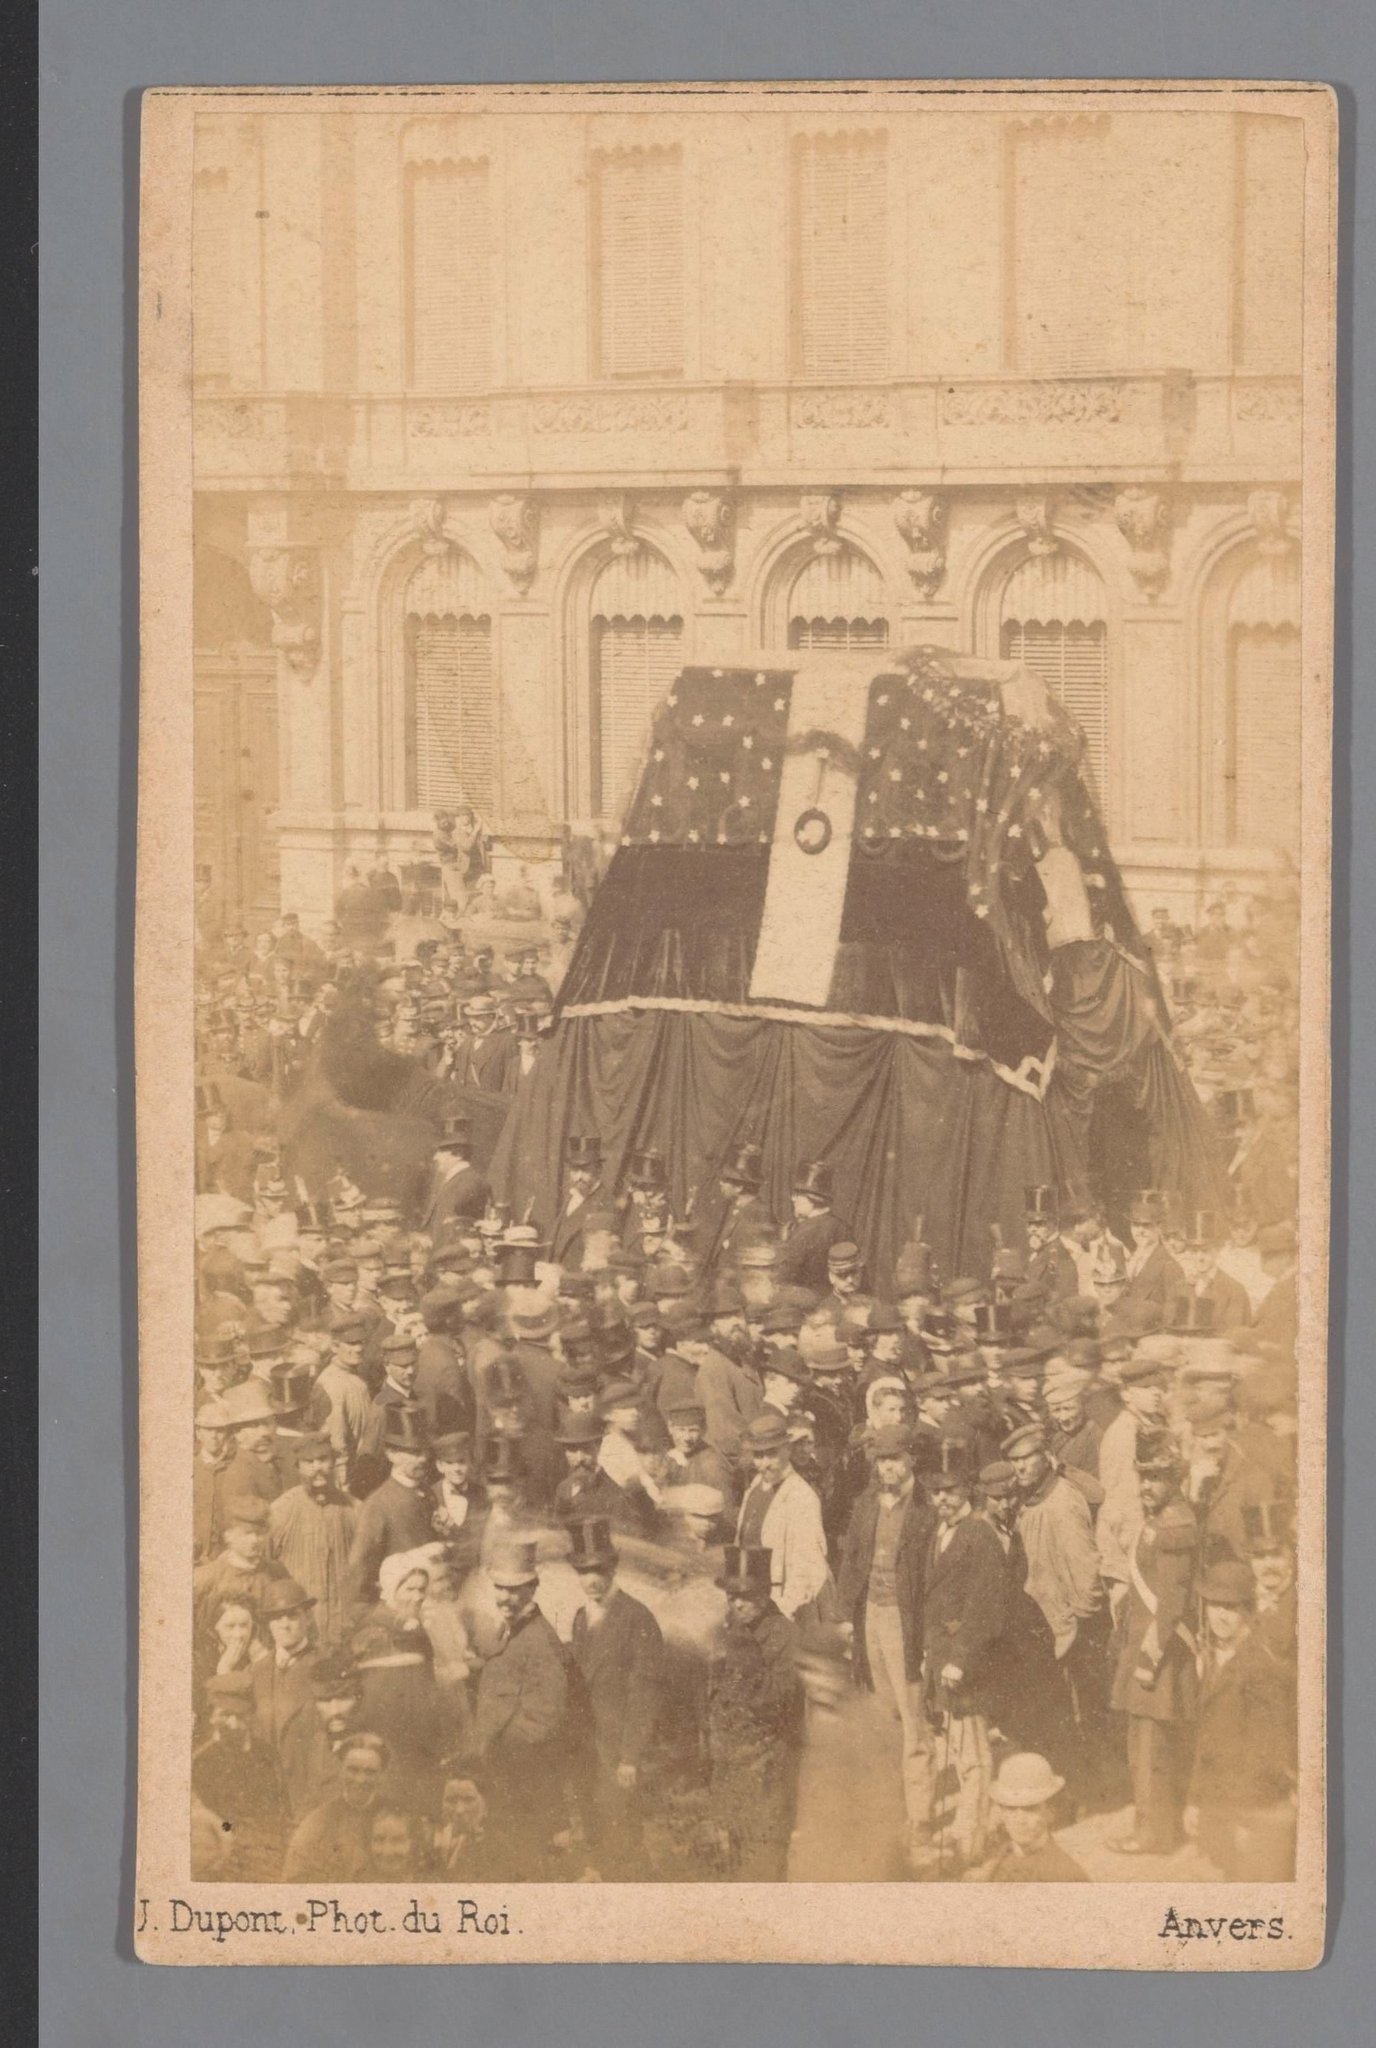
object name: carte de visite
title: Gezicht op de begrafenisstoet van de schilder Henri Leys op 26 augustus 1869 in Antwerpen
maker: joseph dupont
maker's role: fotograaf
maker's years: 1818-1901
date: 1869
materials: cardboard, photographic support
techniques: albumen print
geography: antwerp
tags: antwerp, painter, draughtsman, henri leys (baron), cortege, funeral procession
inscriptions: inscription: ‘J. Dupont,/ Photographe du Roi,/ Place de Meir, 32,/ Anvers./ Maison fondée en 1853./ Tous les clichés ont été conservés.’, annotation: ‘Les funérailles de Henri Leys (baron)/ célèbre peintre/ le août 1869.’, number: ‘1815’